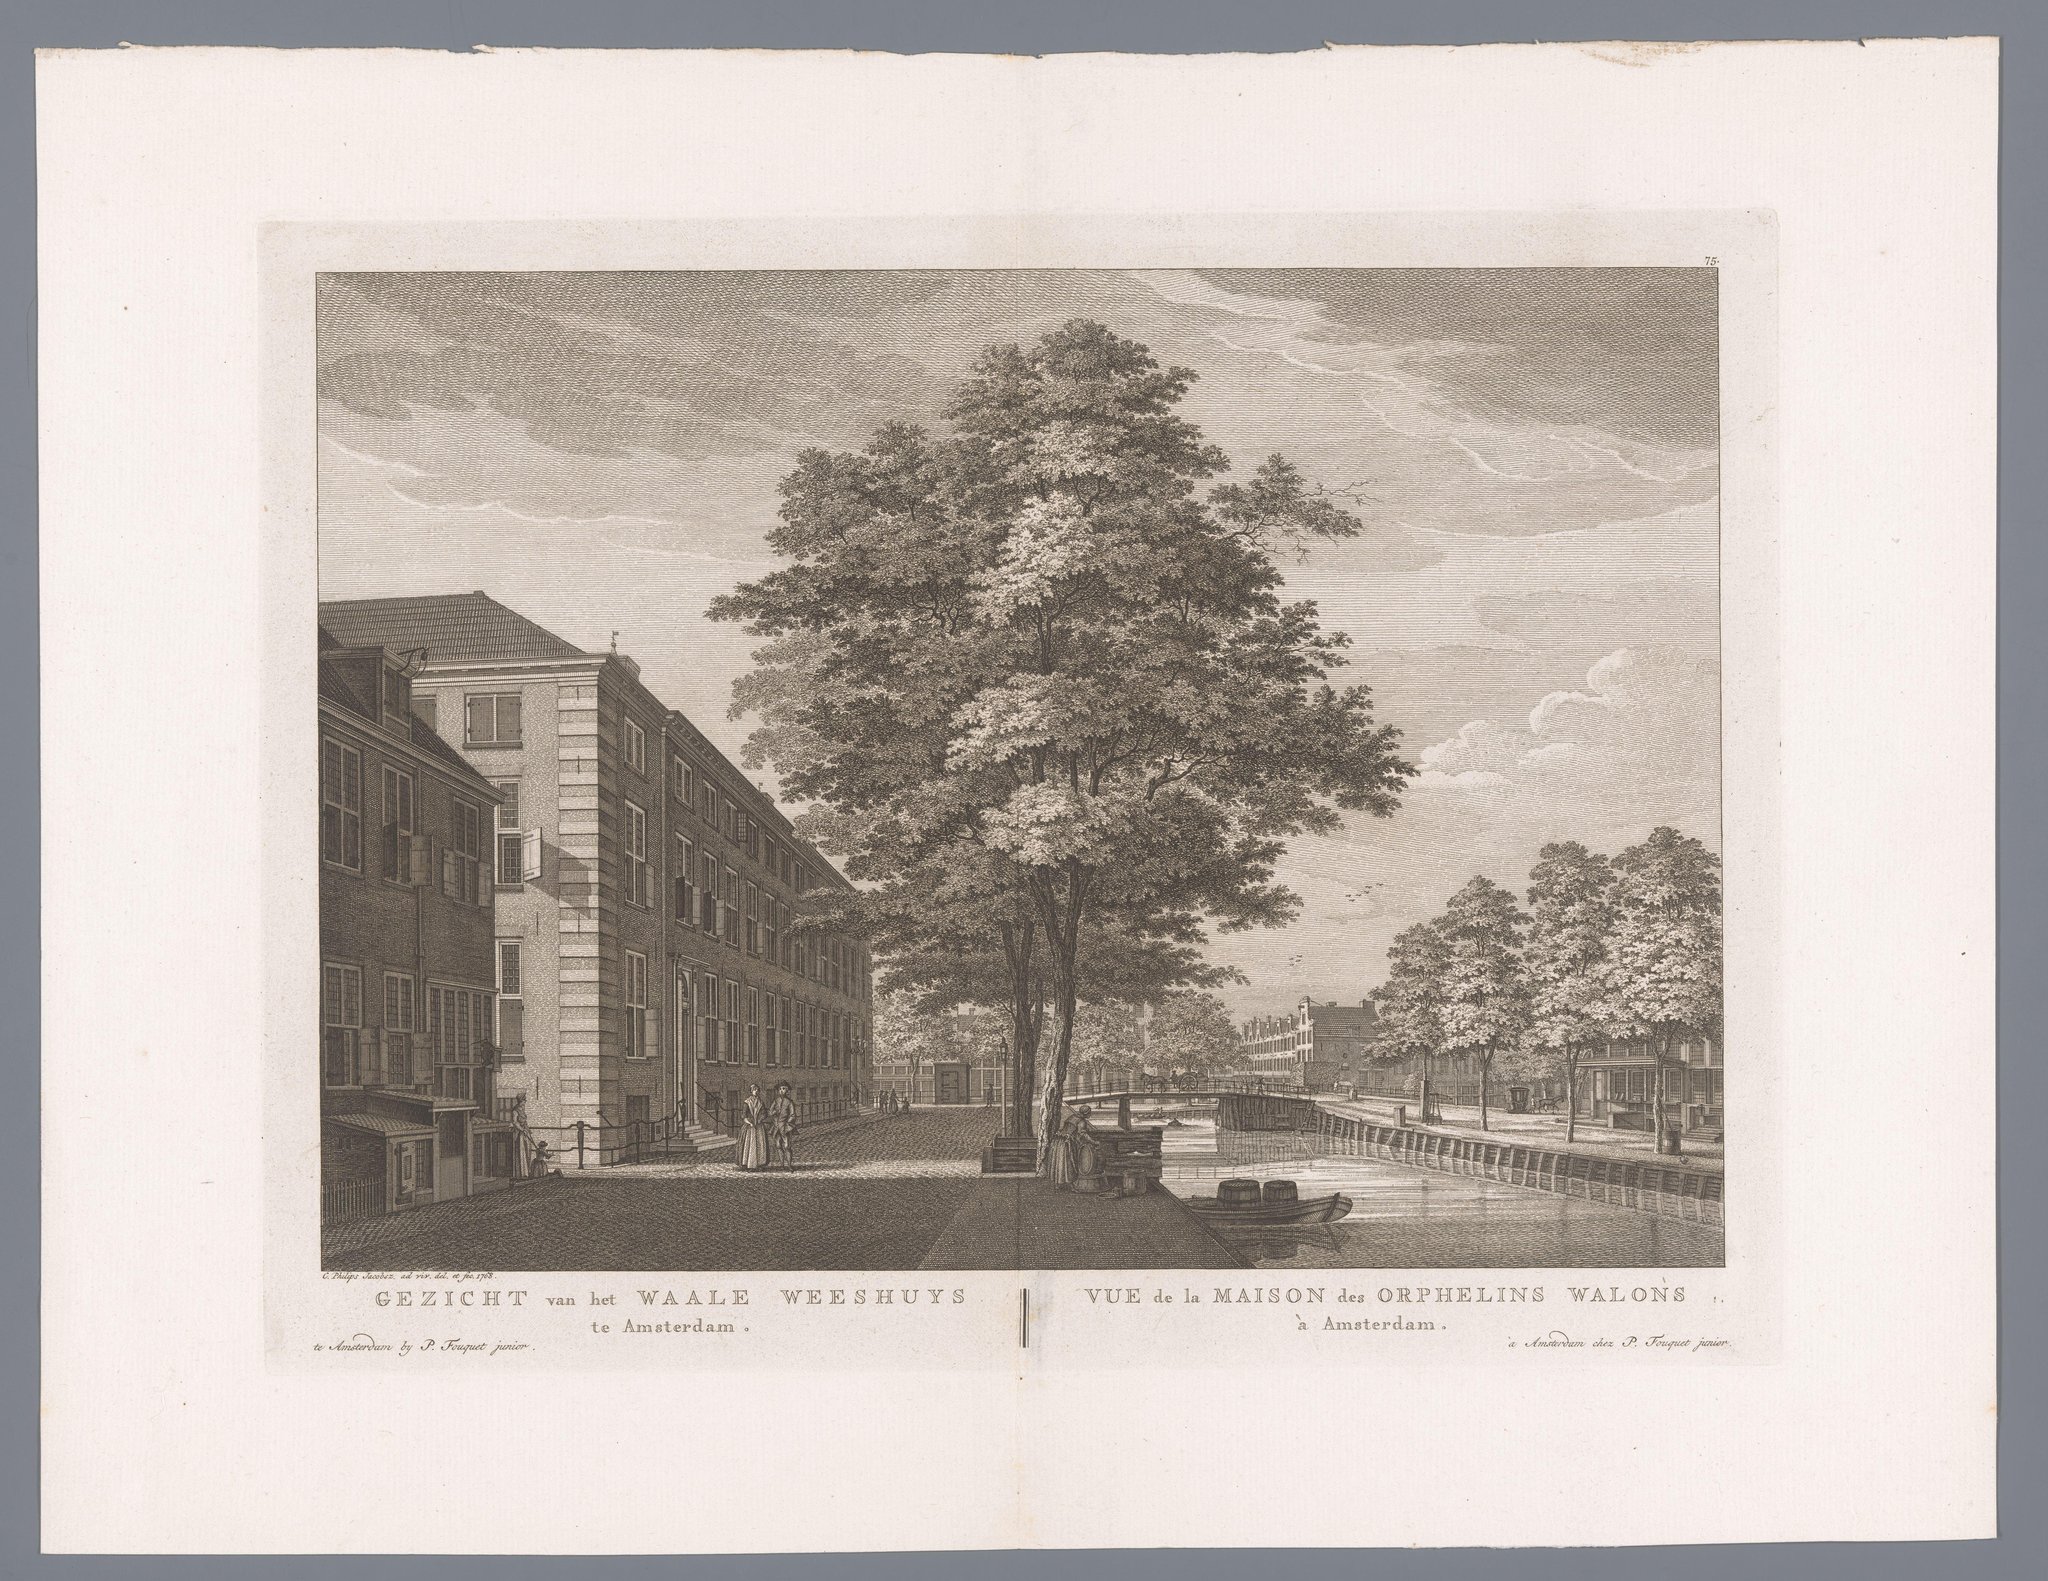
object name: print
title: Gezicht van het Waale Weeshuys te Amsterdam / Vue de la maison des orphelins Walons à Amsterdam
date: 1778-1783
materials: paper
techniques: engraving, etching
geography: amsterdam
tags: orphanage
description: Prent uit een van de edities van de Atlas Fouquet: Afbeeldingen van de wyd-vermaarde koopstad Amsterdam benevens des zelvs voornaamste gebouwen en gezigten alle naar het leeven getekend / Receuil des edifices les plus considerables et des plus belles vues, de la fameuse ville d'Amsterdam, dessinées d'après nature. Amsterdam: Pierre Fouquet, 1778-1783. En: Nieuwe atlas, van de voornaamste gebouwen en gezigten der stad Amsterdam, met derzelver beknopte beschryvingen. 2 dln. Amsterdam: Daniël Jean Changuion en Petrus den Hengst [in opdracht van Pierre Fouquet], 1783. Een latere staat komt voor in: Nieuwe atlas, van de voornaamste gebouwen en gezigten der stad Amsterdam. Met derzelver beknopte beschryvingen. Amsterdam: Evert Maaskamp, 1805.